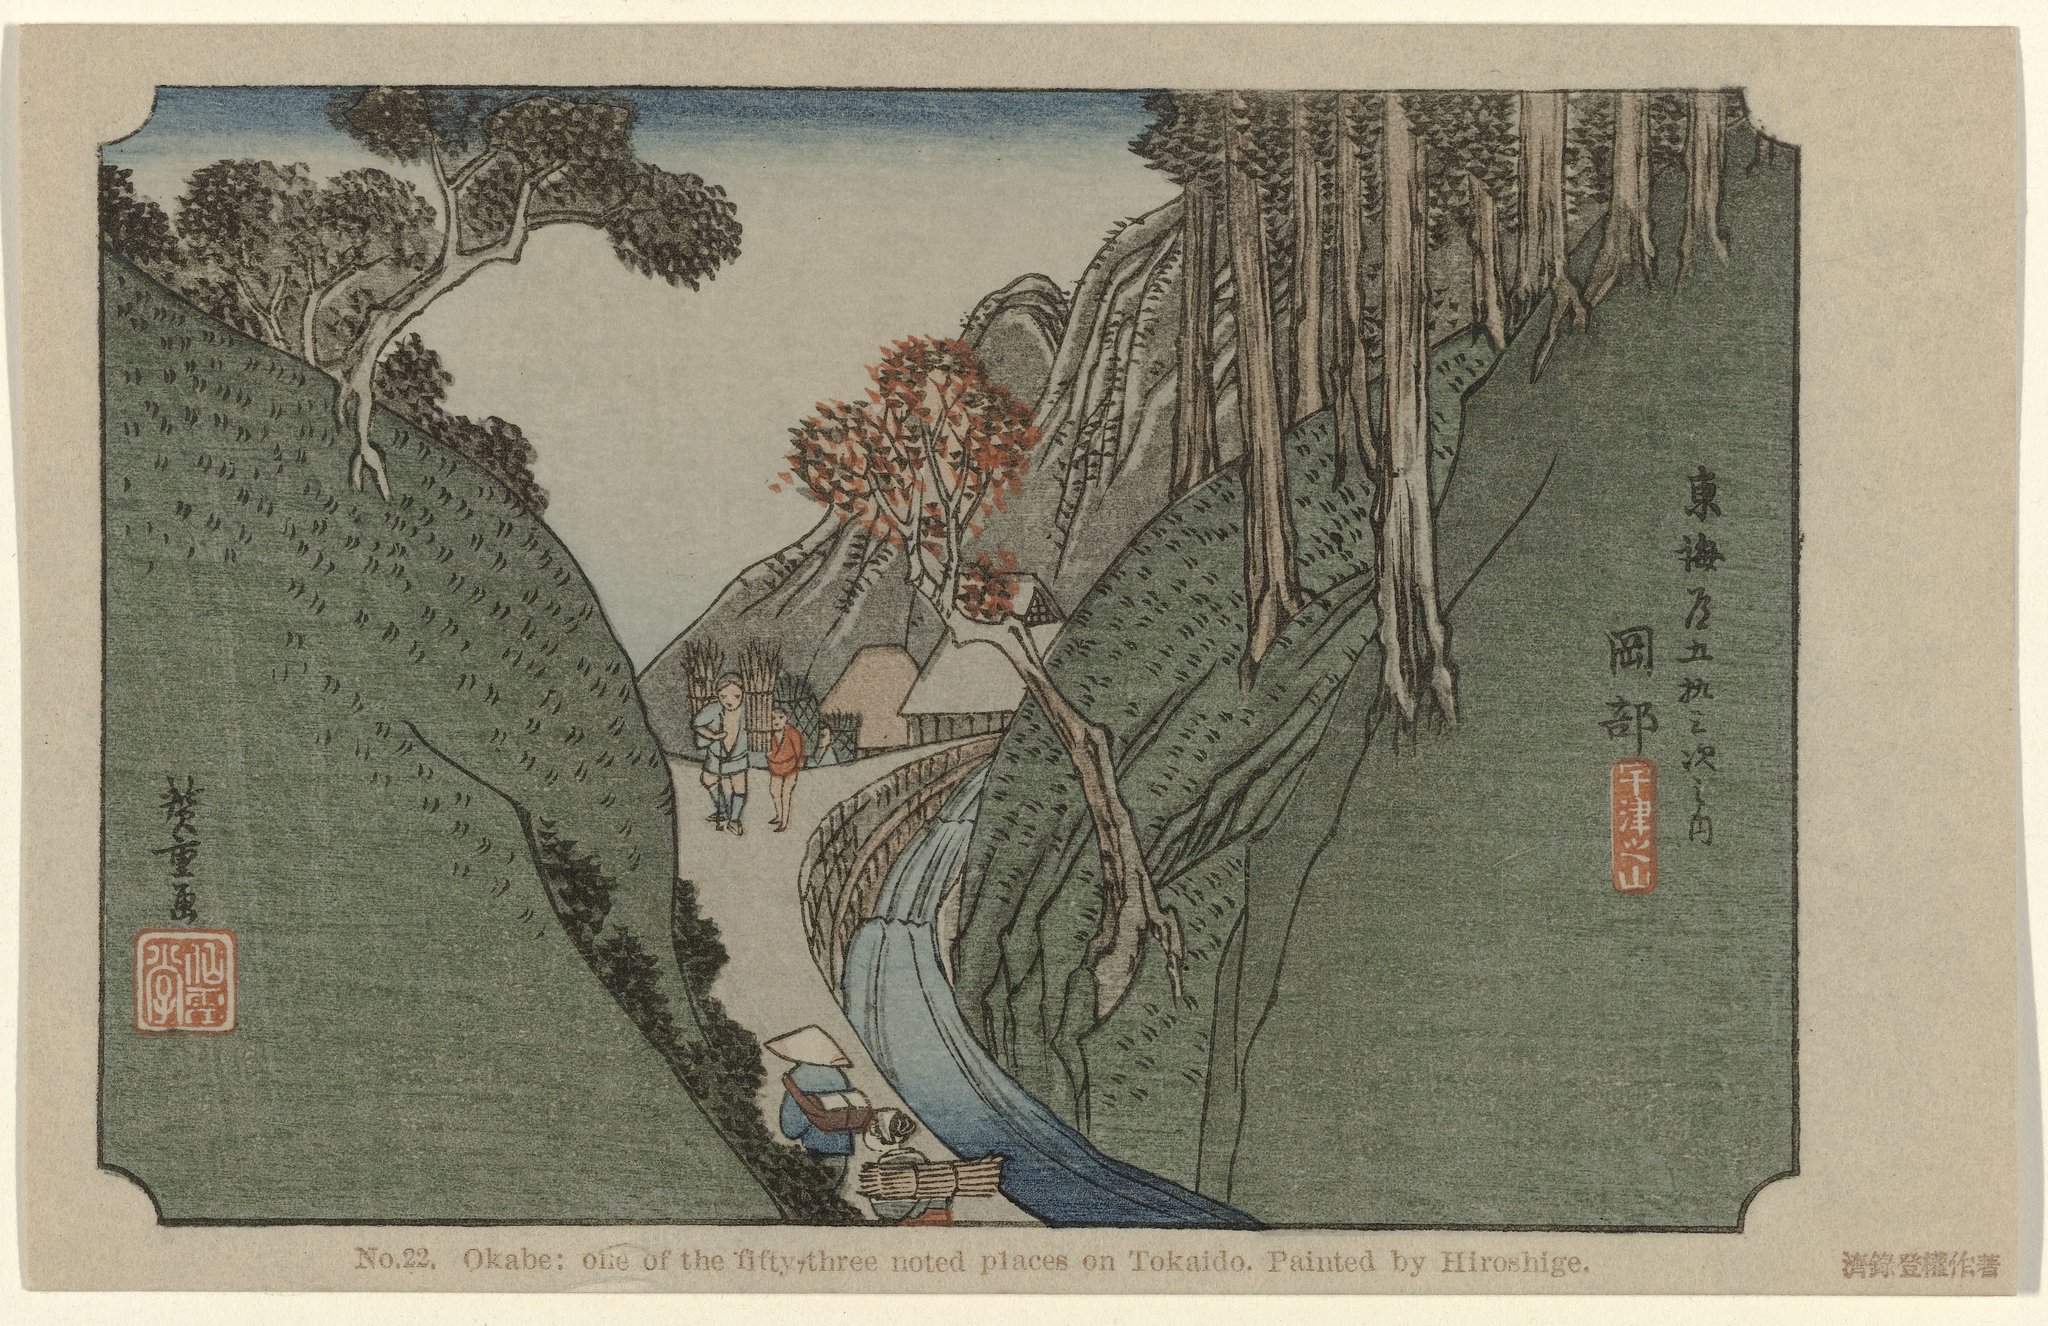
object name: ansichtkaart, prentbriefkaart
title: Hiroshige no fude Tôkaidô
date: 1906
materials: cardboard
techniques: woodcut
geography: japan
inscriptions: date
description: Reizigers lopen door een smalle doorgang langs een rivier, een dorpje in de verte.